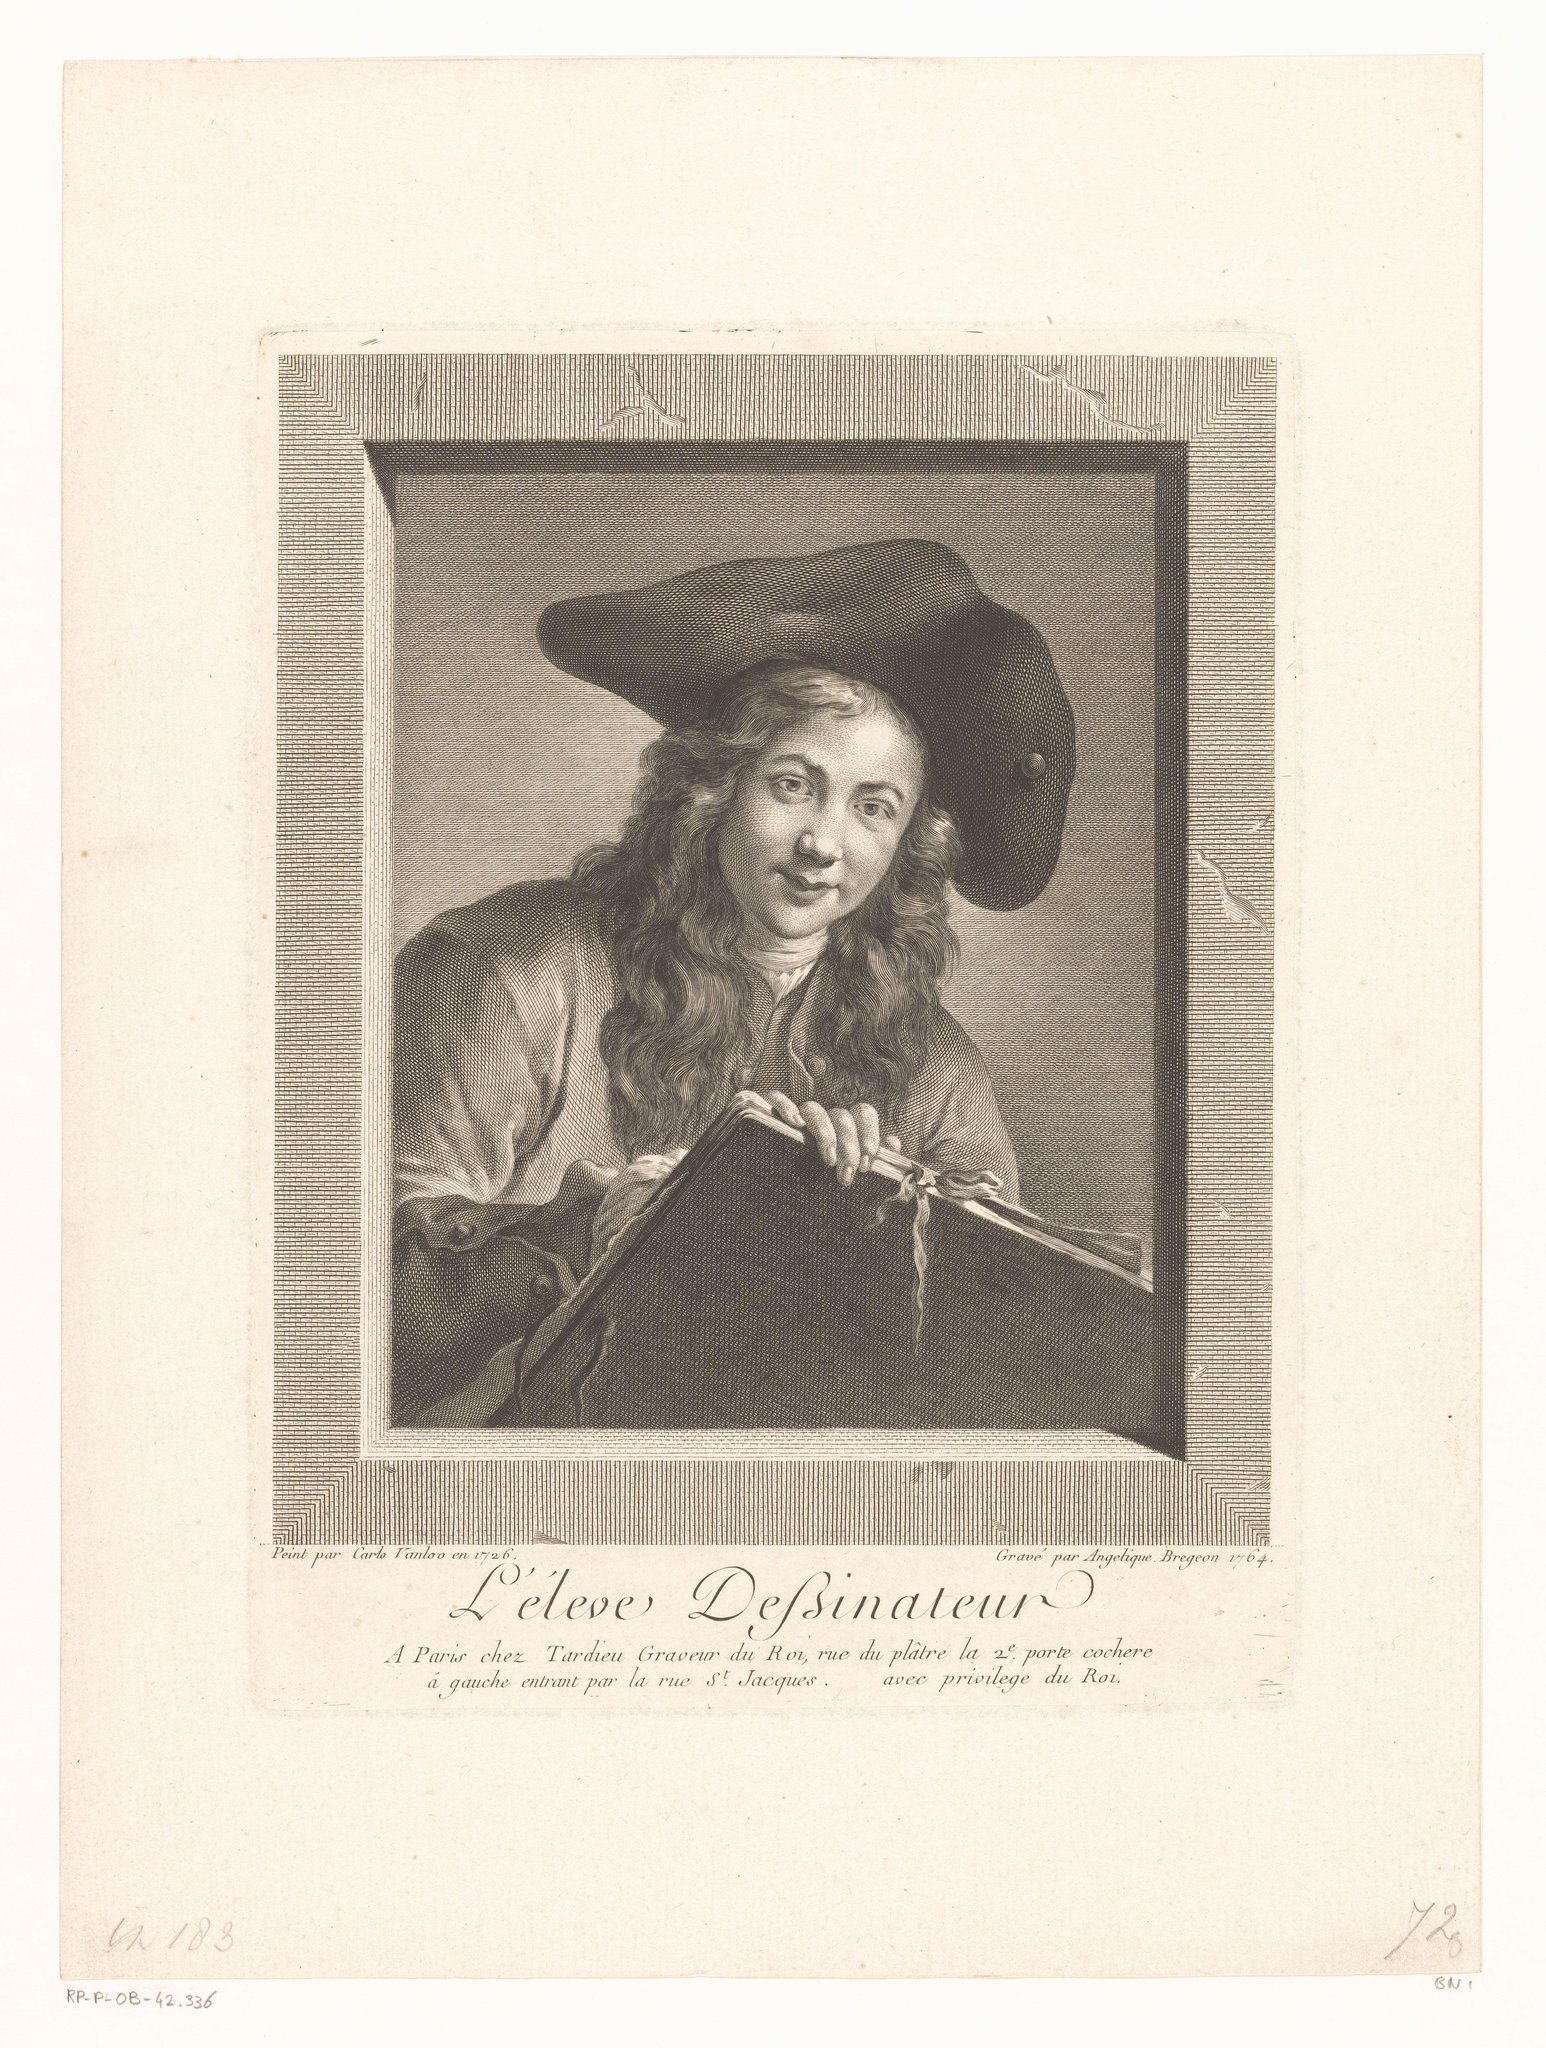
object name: print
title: L'éleve Dessinateur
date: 1764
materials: paper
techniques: engraving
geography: paris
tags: draughtsman at work, drawing-lesson, artist at work, in his workshop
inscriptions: collector's mark: Lugt 240